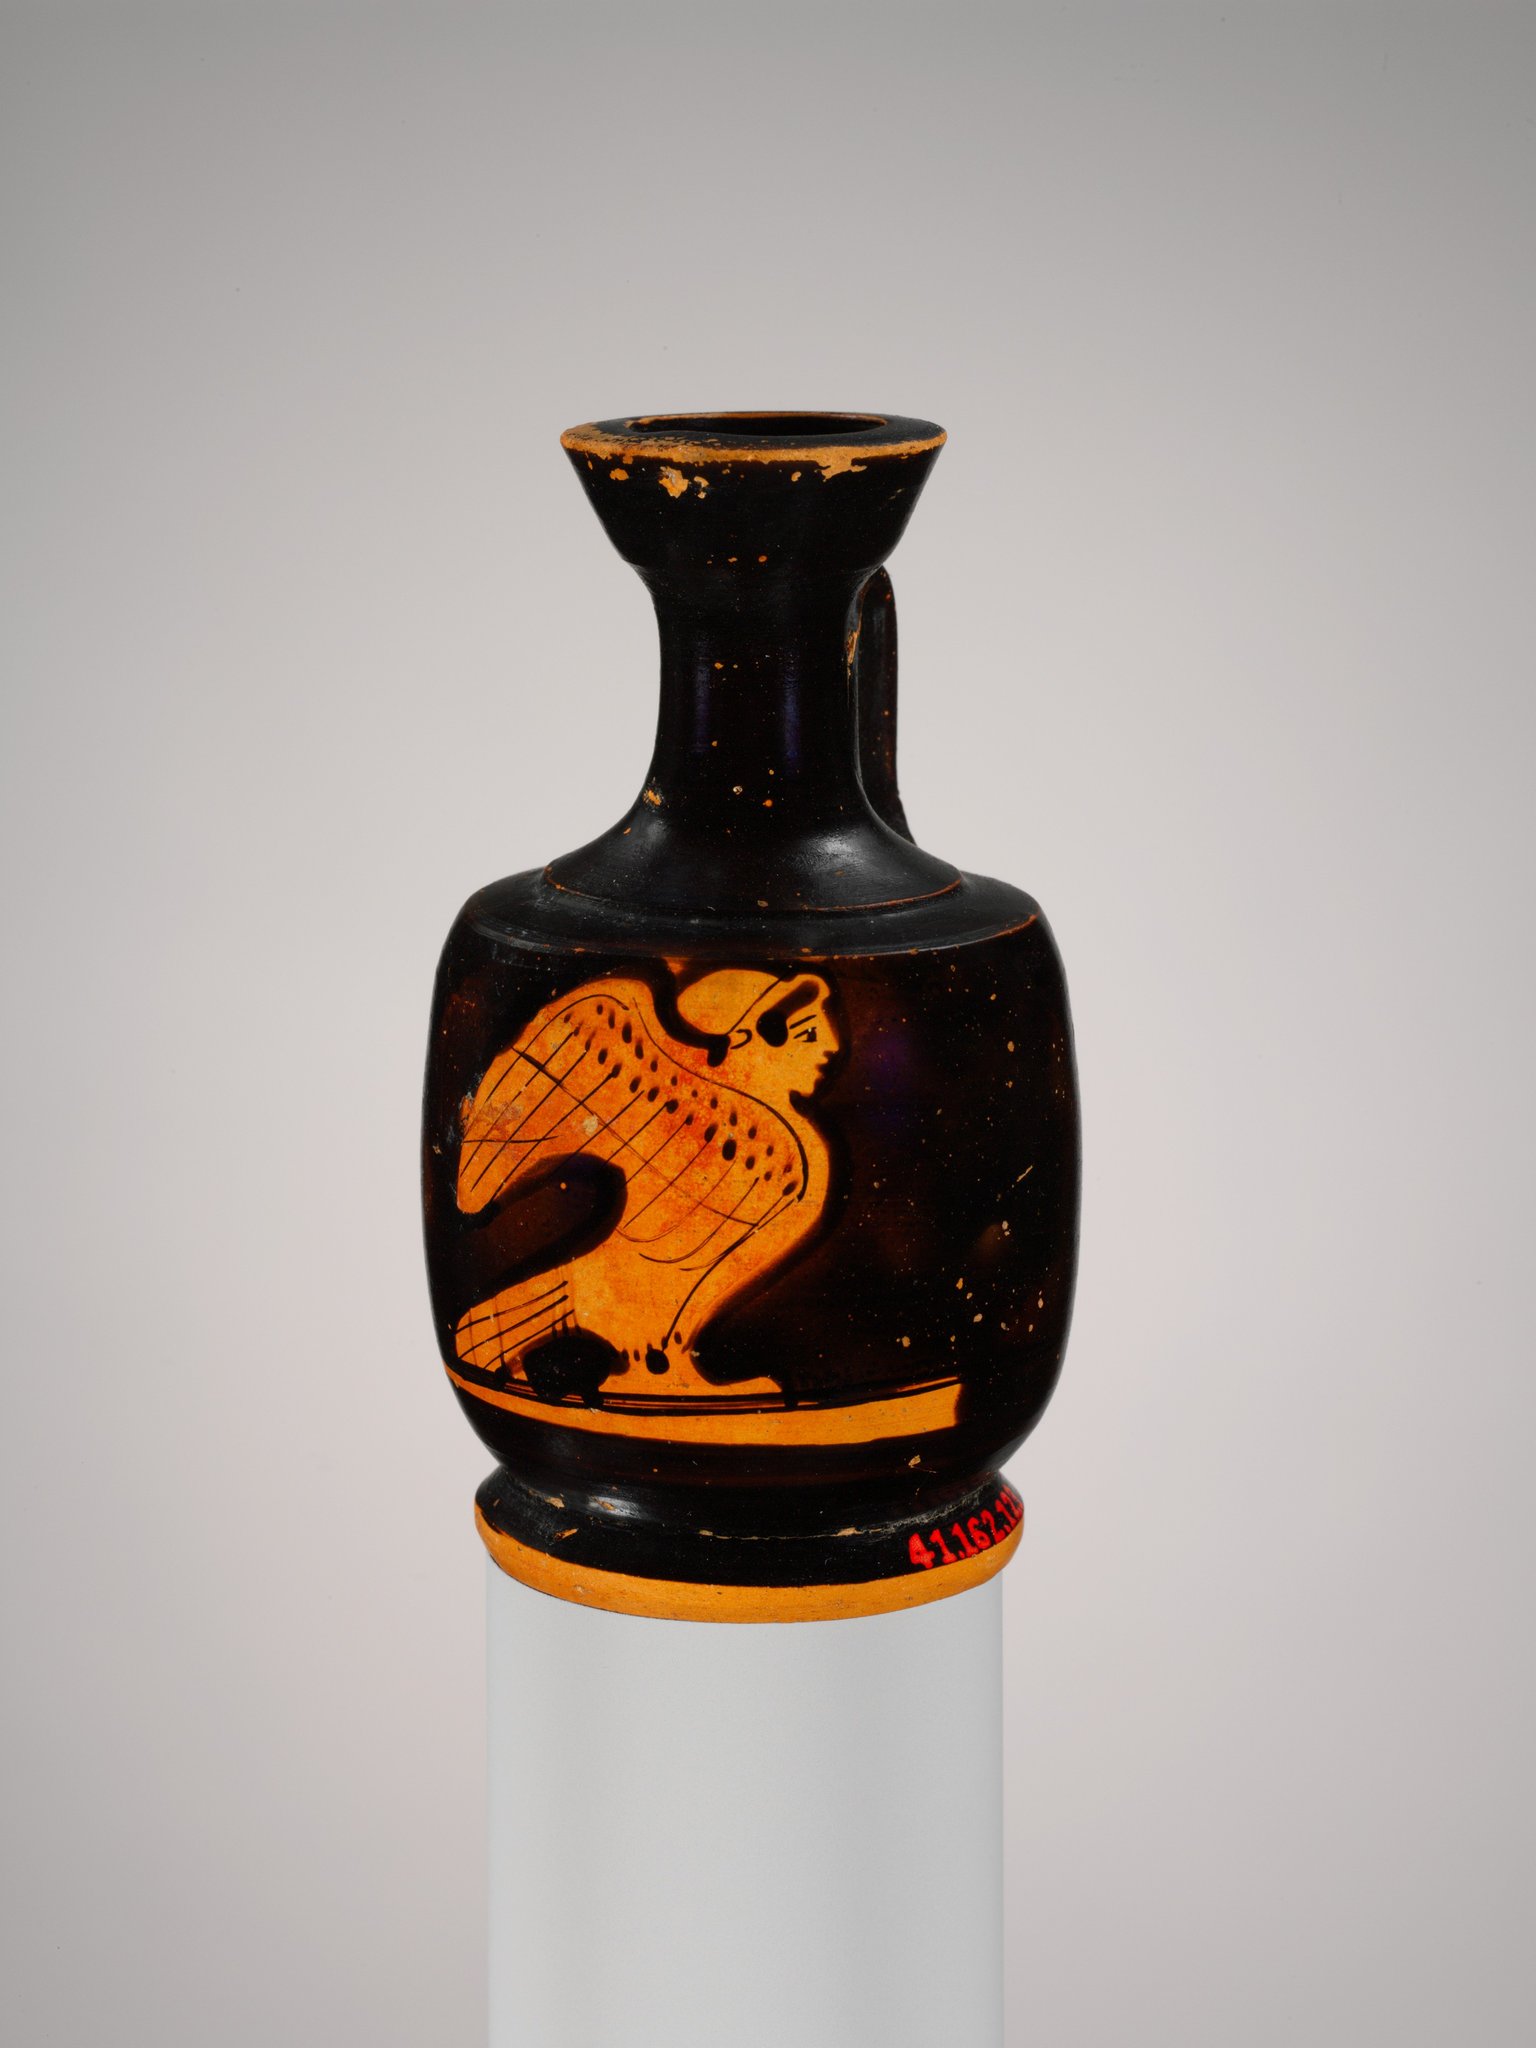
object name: squat lekythos, miniature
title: Miniature terracotta squat lekythos (oil flask) with siren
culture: greek, attic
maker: seireniske painter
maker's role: artist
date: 467-435 BCE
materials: terracotta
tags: sirens